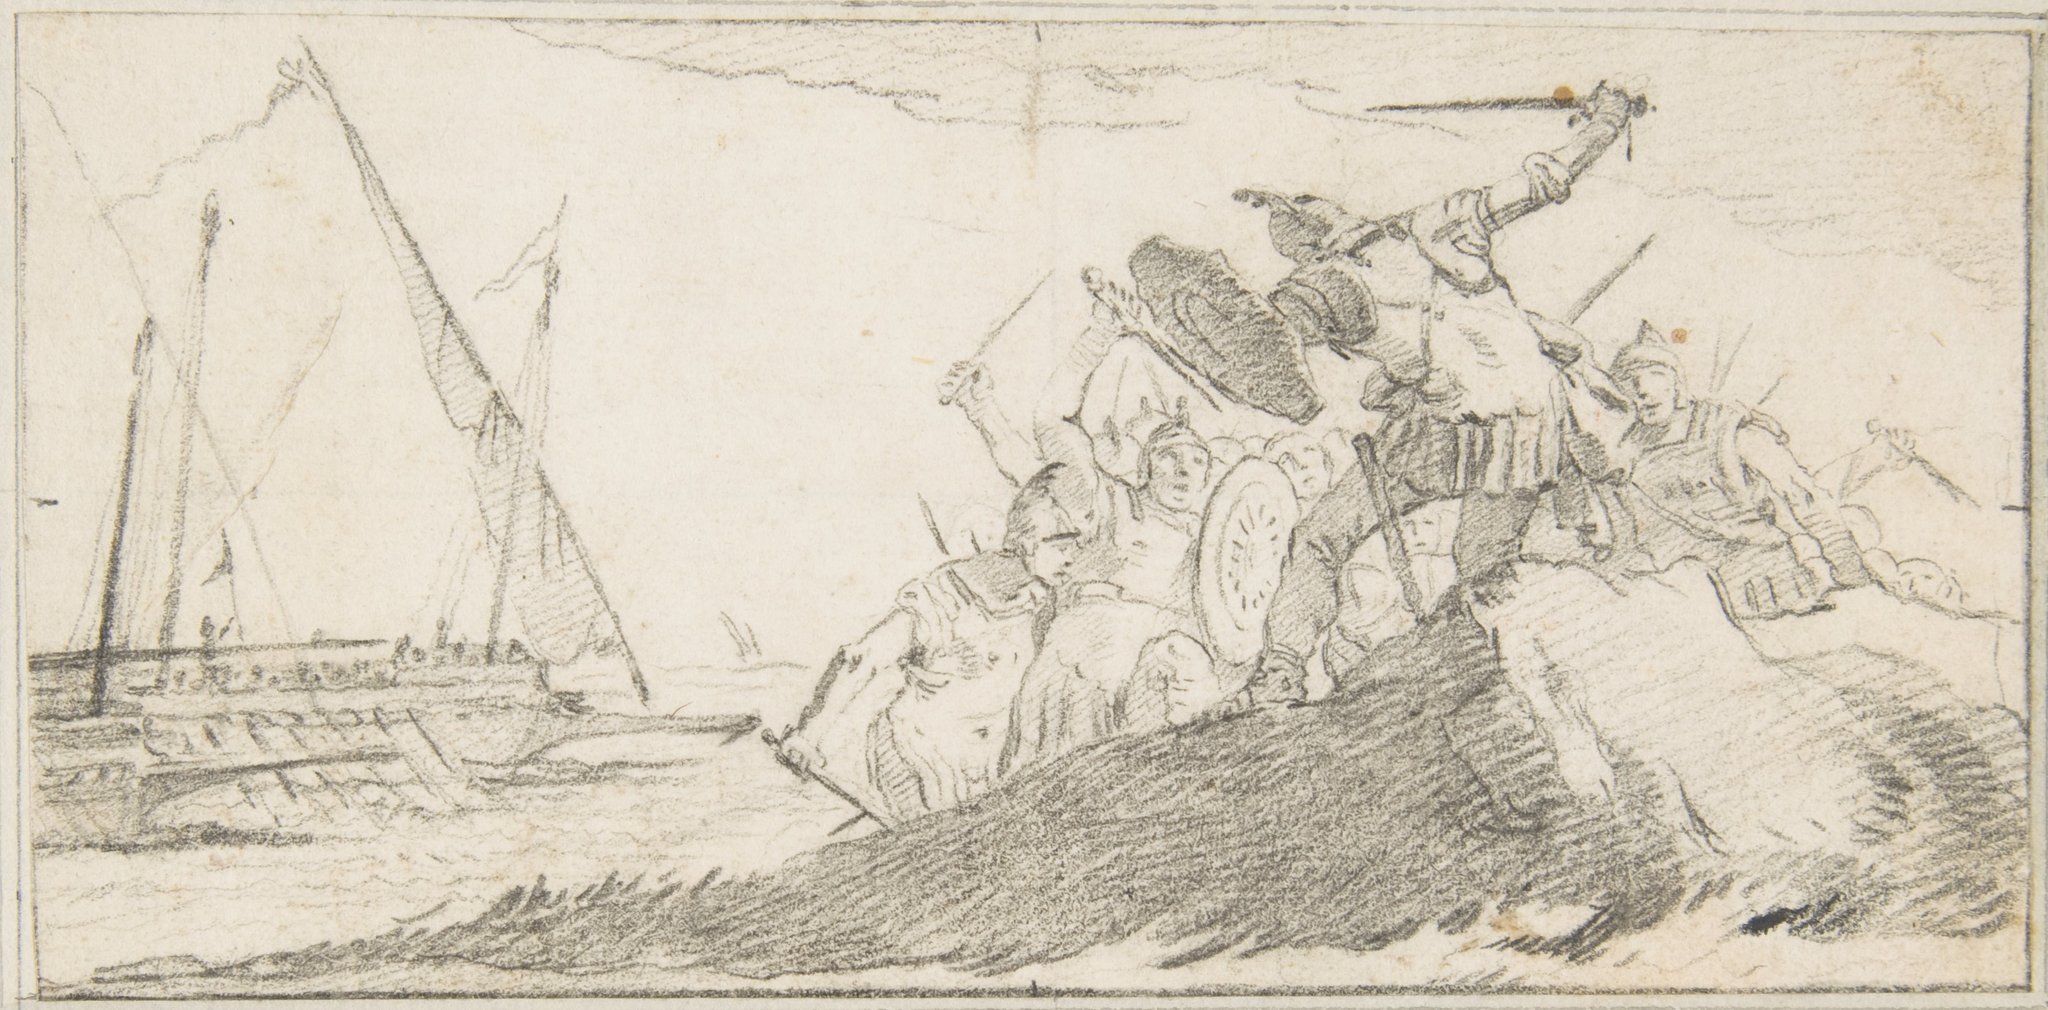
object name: drawing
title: Illustration for a Book: Battle by the Sea Coast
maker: giovanni battista tiepolo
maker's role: artist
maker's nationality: italian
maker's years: 1696-1770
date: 1696-1770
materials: chalk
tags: battles,soldiers,shields,swords,ships